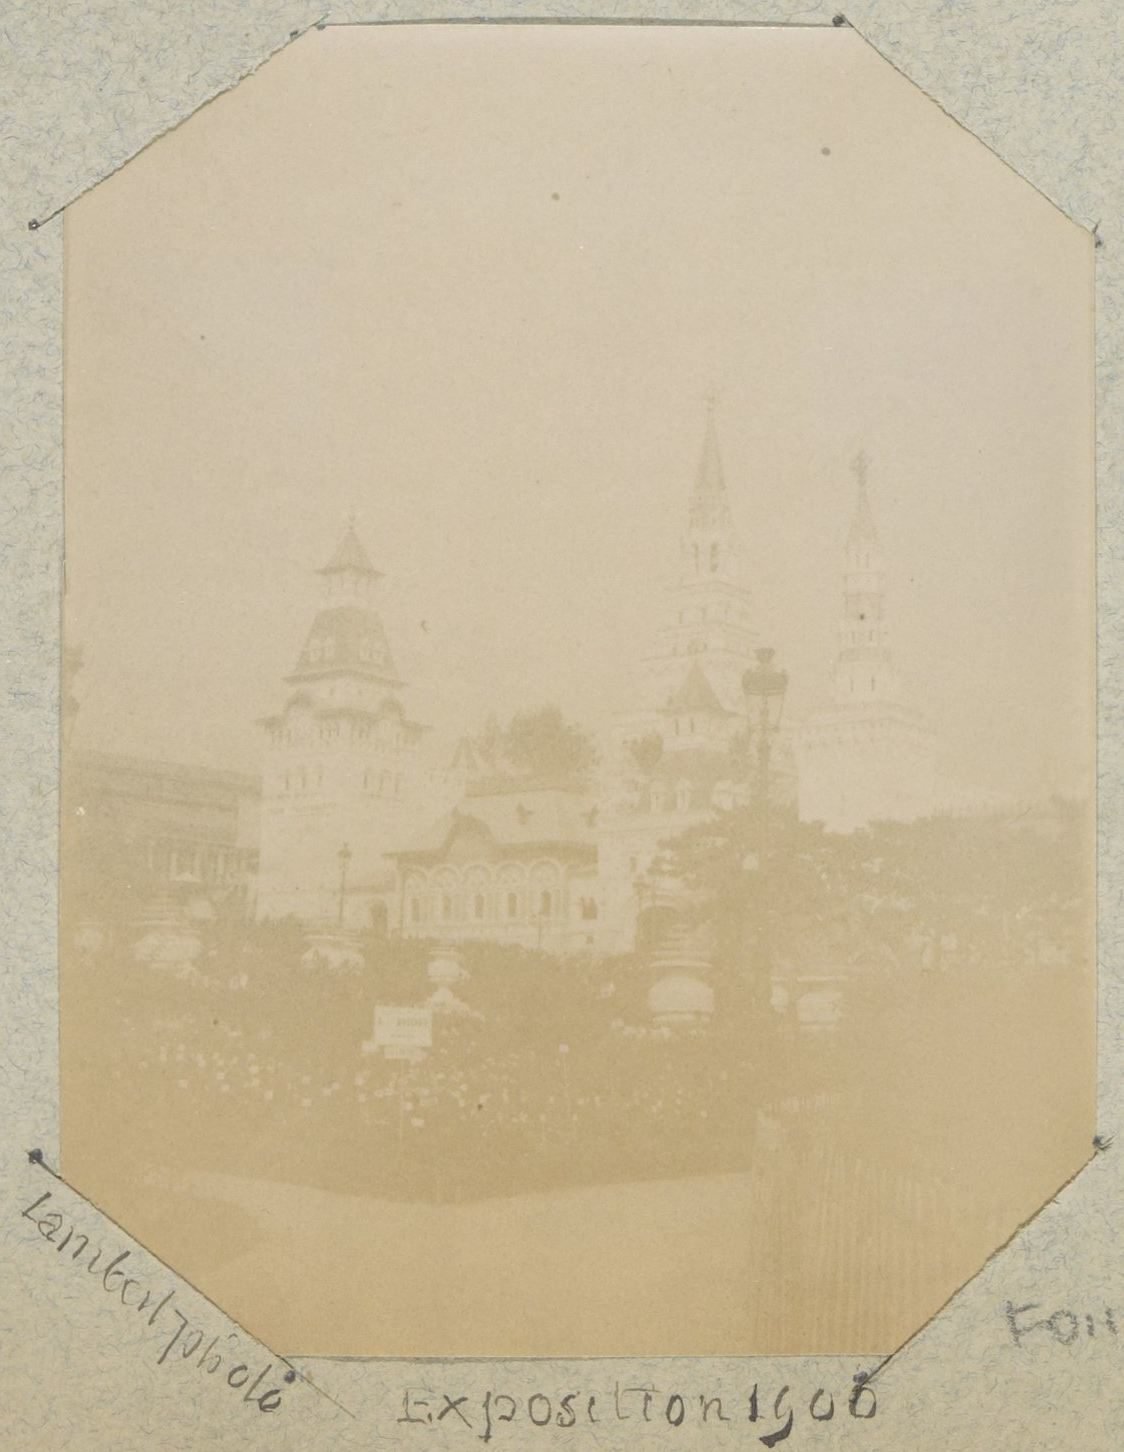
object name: album leaf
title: Gezicht op het paviljoen van Rusland tijdens de Wereldtentoonstelling van 1900 in Parijs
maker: lambert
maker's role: painter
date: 1900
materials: paper, photographic support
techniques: albumen print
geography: paris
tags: world fair, world exhibition, palace, paris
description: Onderdeel van Album van een Franse amateur met foto's van Frankrijk, Algerije, Palmyra, de Wereldtentoonstelling van 1900 en van bekende Fransen.